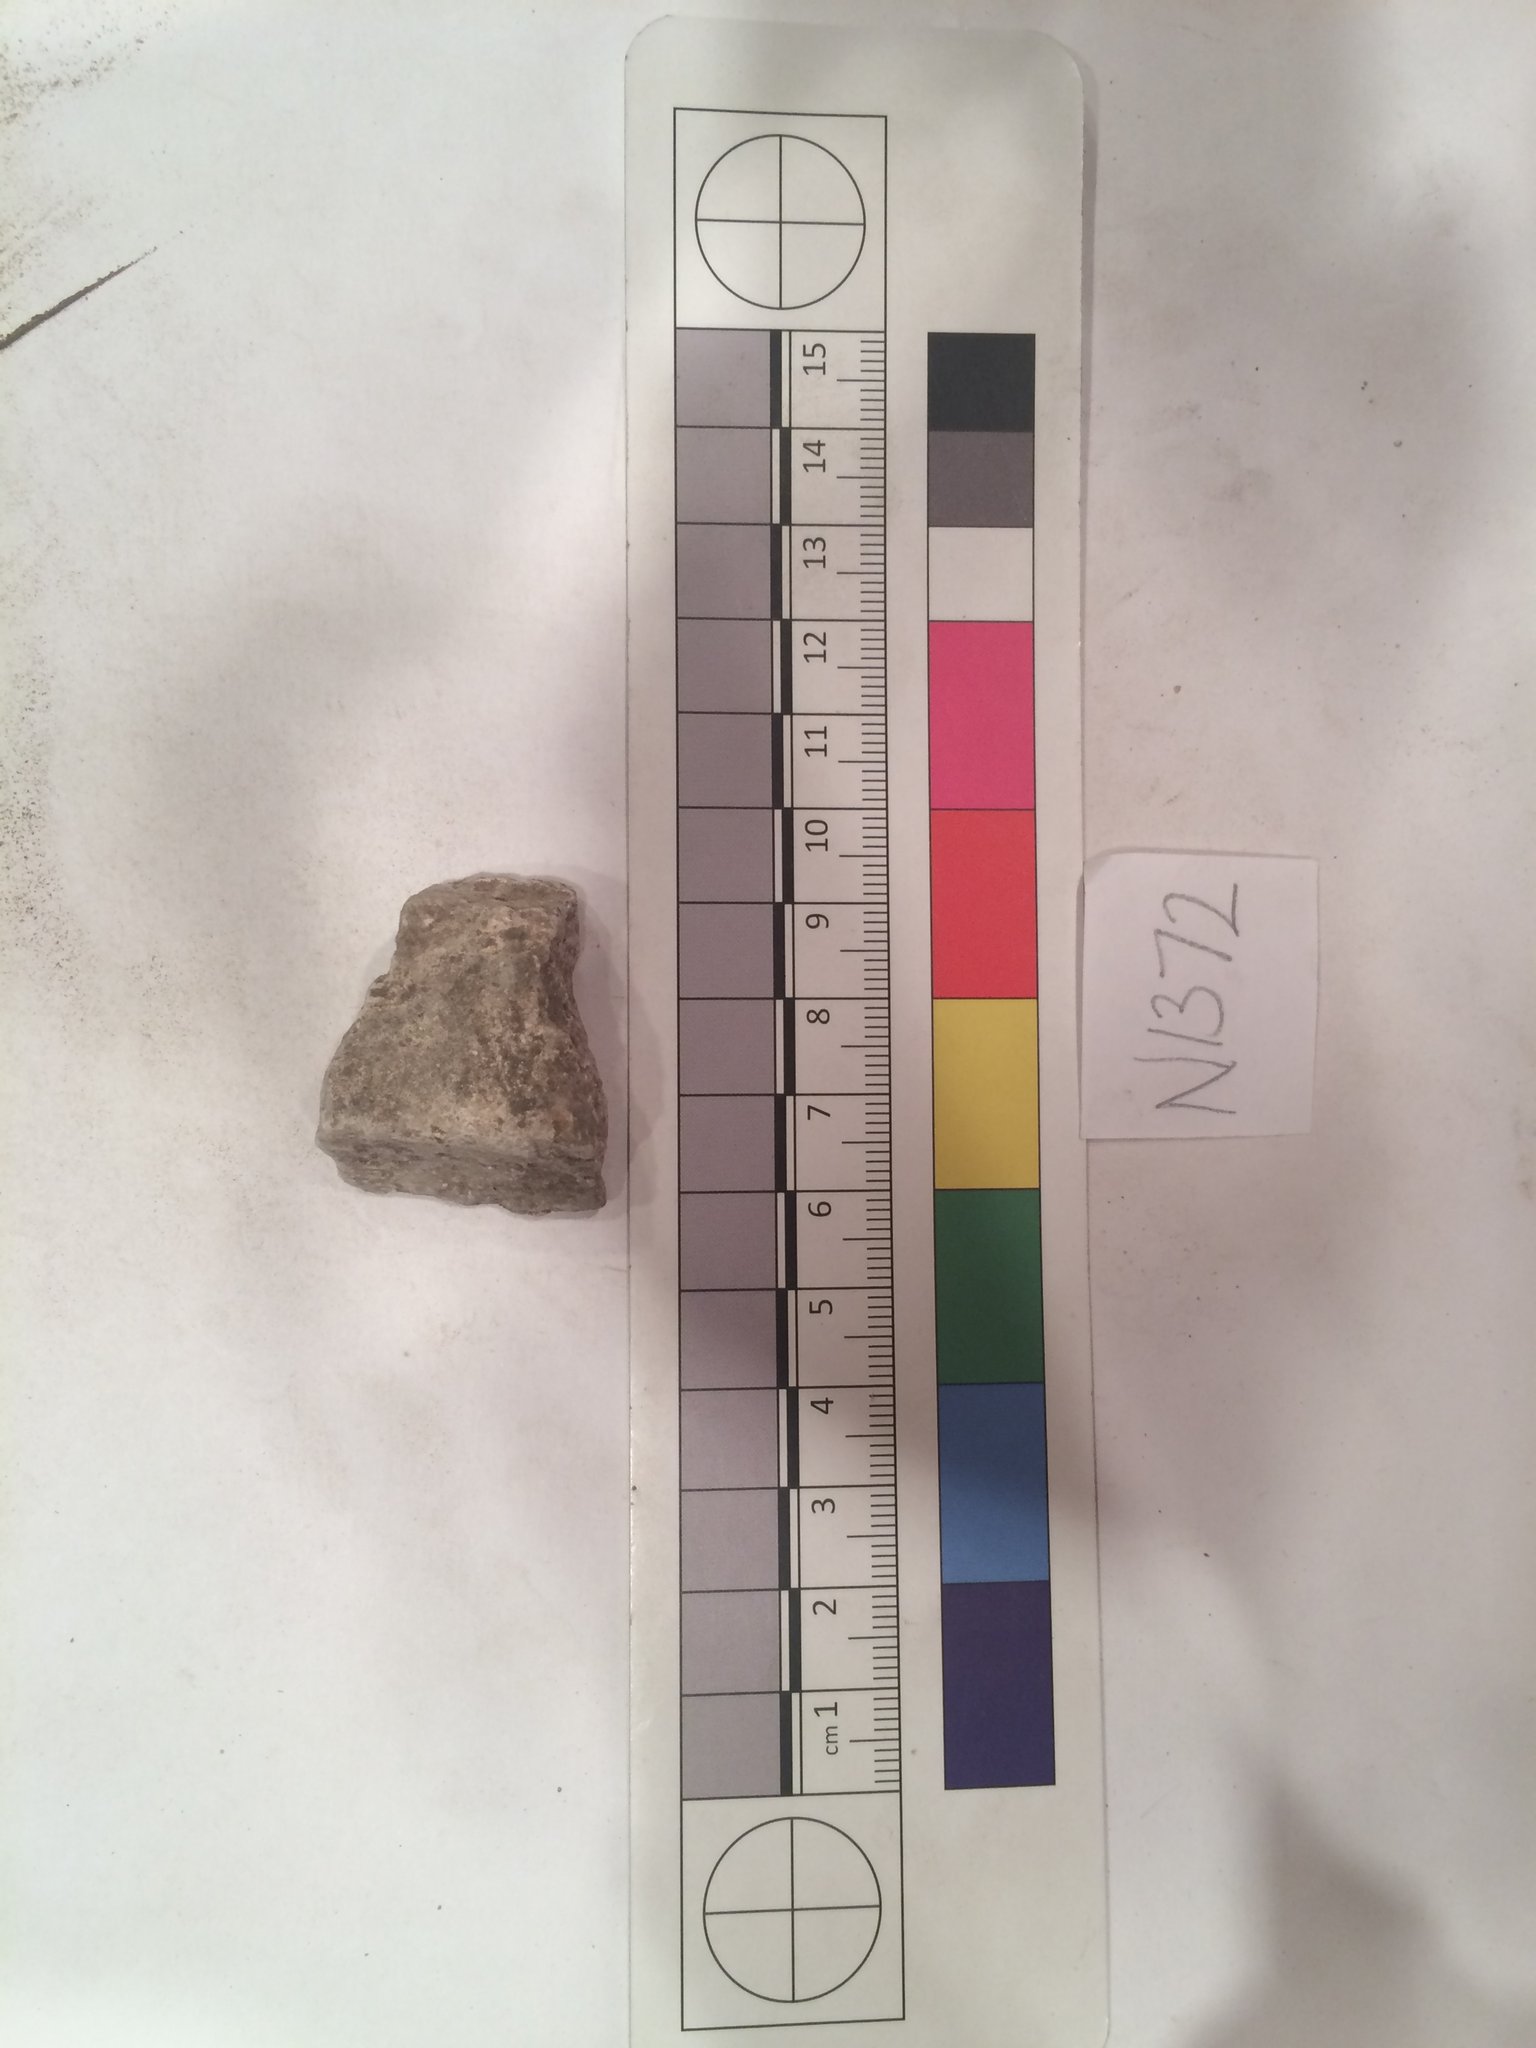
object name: fragment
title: Stucco Fragment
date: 701-1200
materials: plaster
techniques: carving, painting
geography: iran